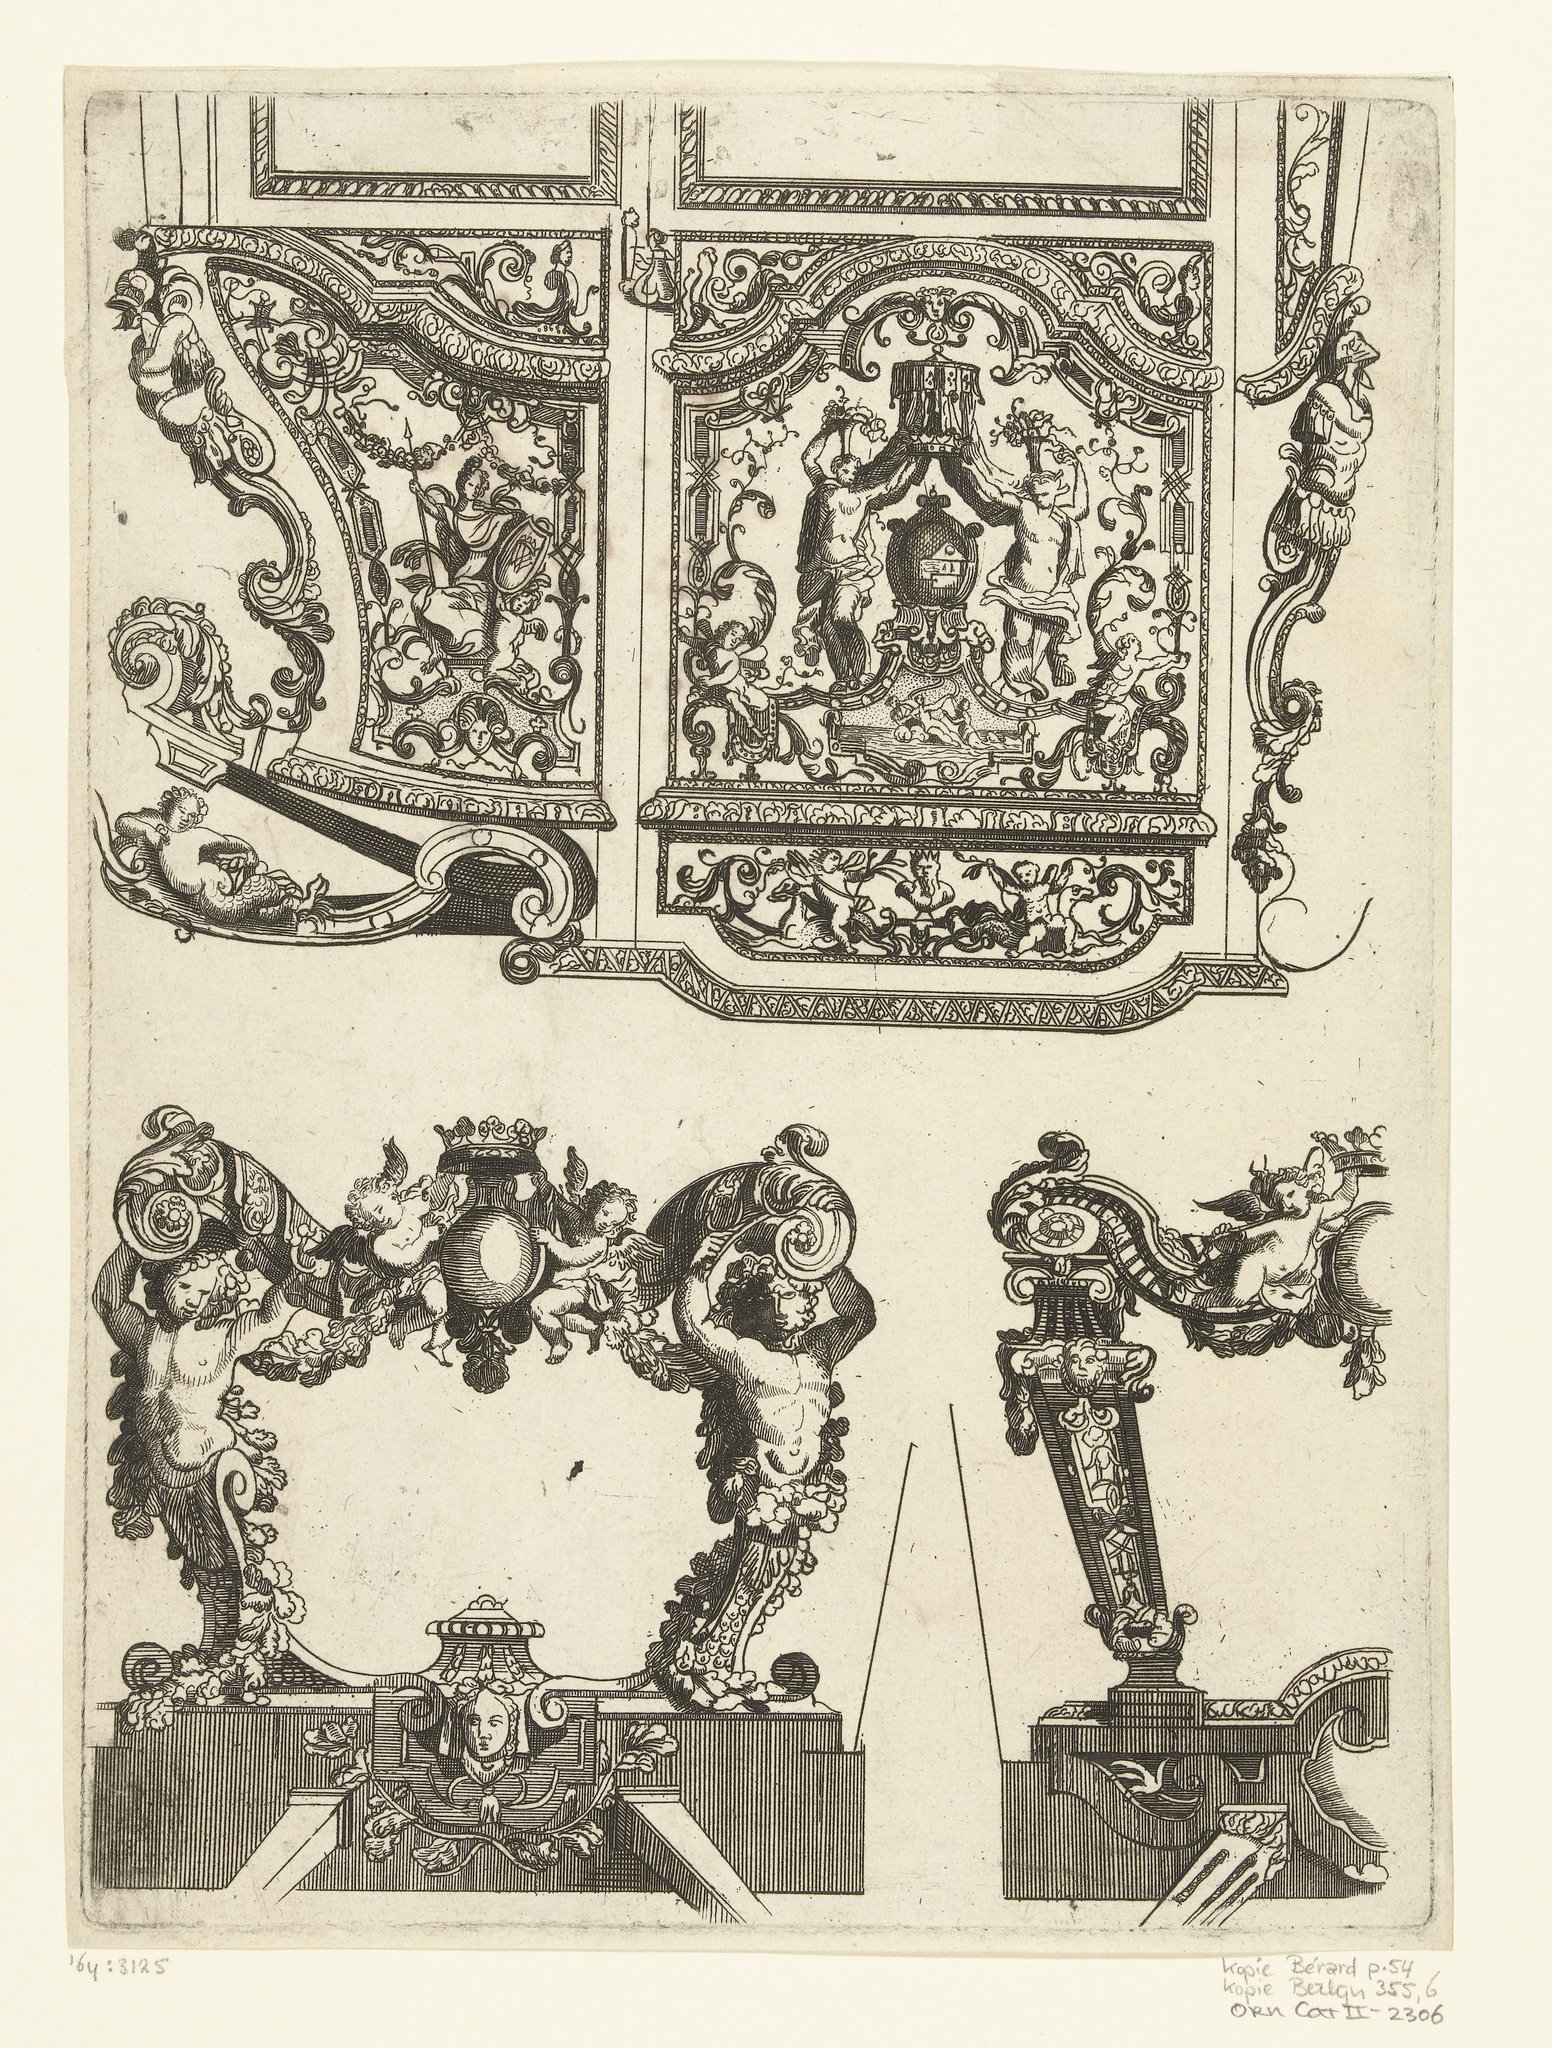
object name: ornament print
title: Koetsen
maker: Anonymous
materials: paper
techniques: etching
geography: netherlands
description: Onderzijde van een koets met panelen met grotesken, daaronder twee variaties voor de omlijsting aan de achterzijde van de koets. Uit serie van 6 bladen.